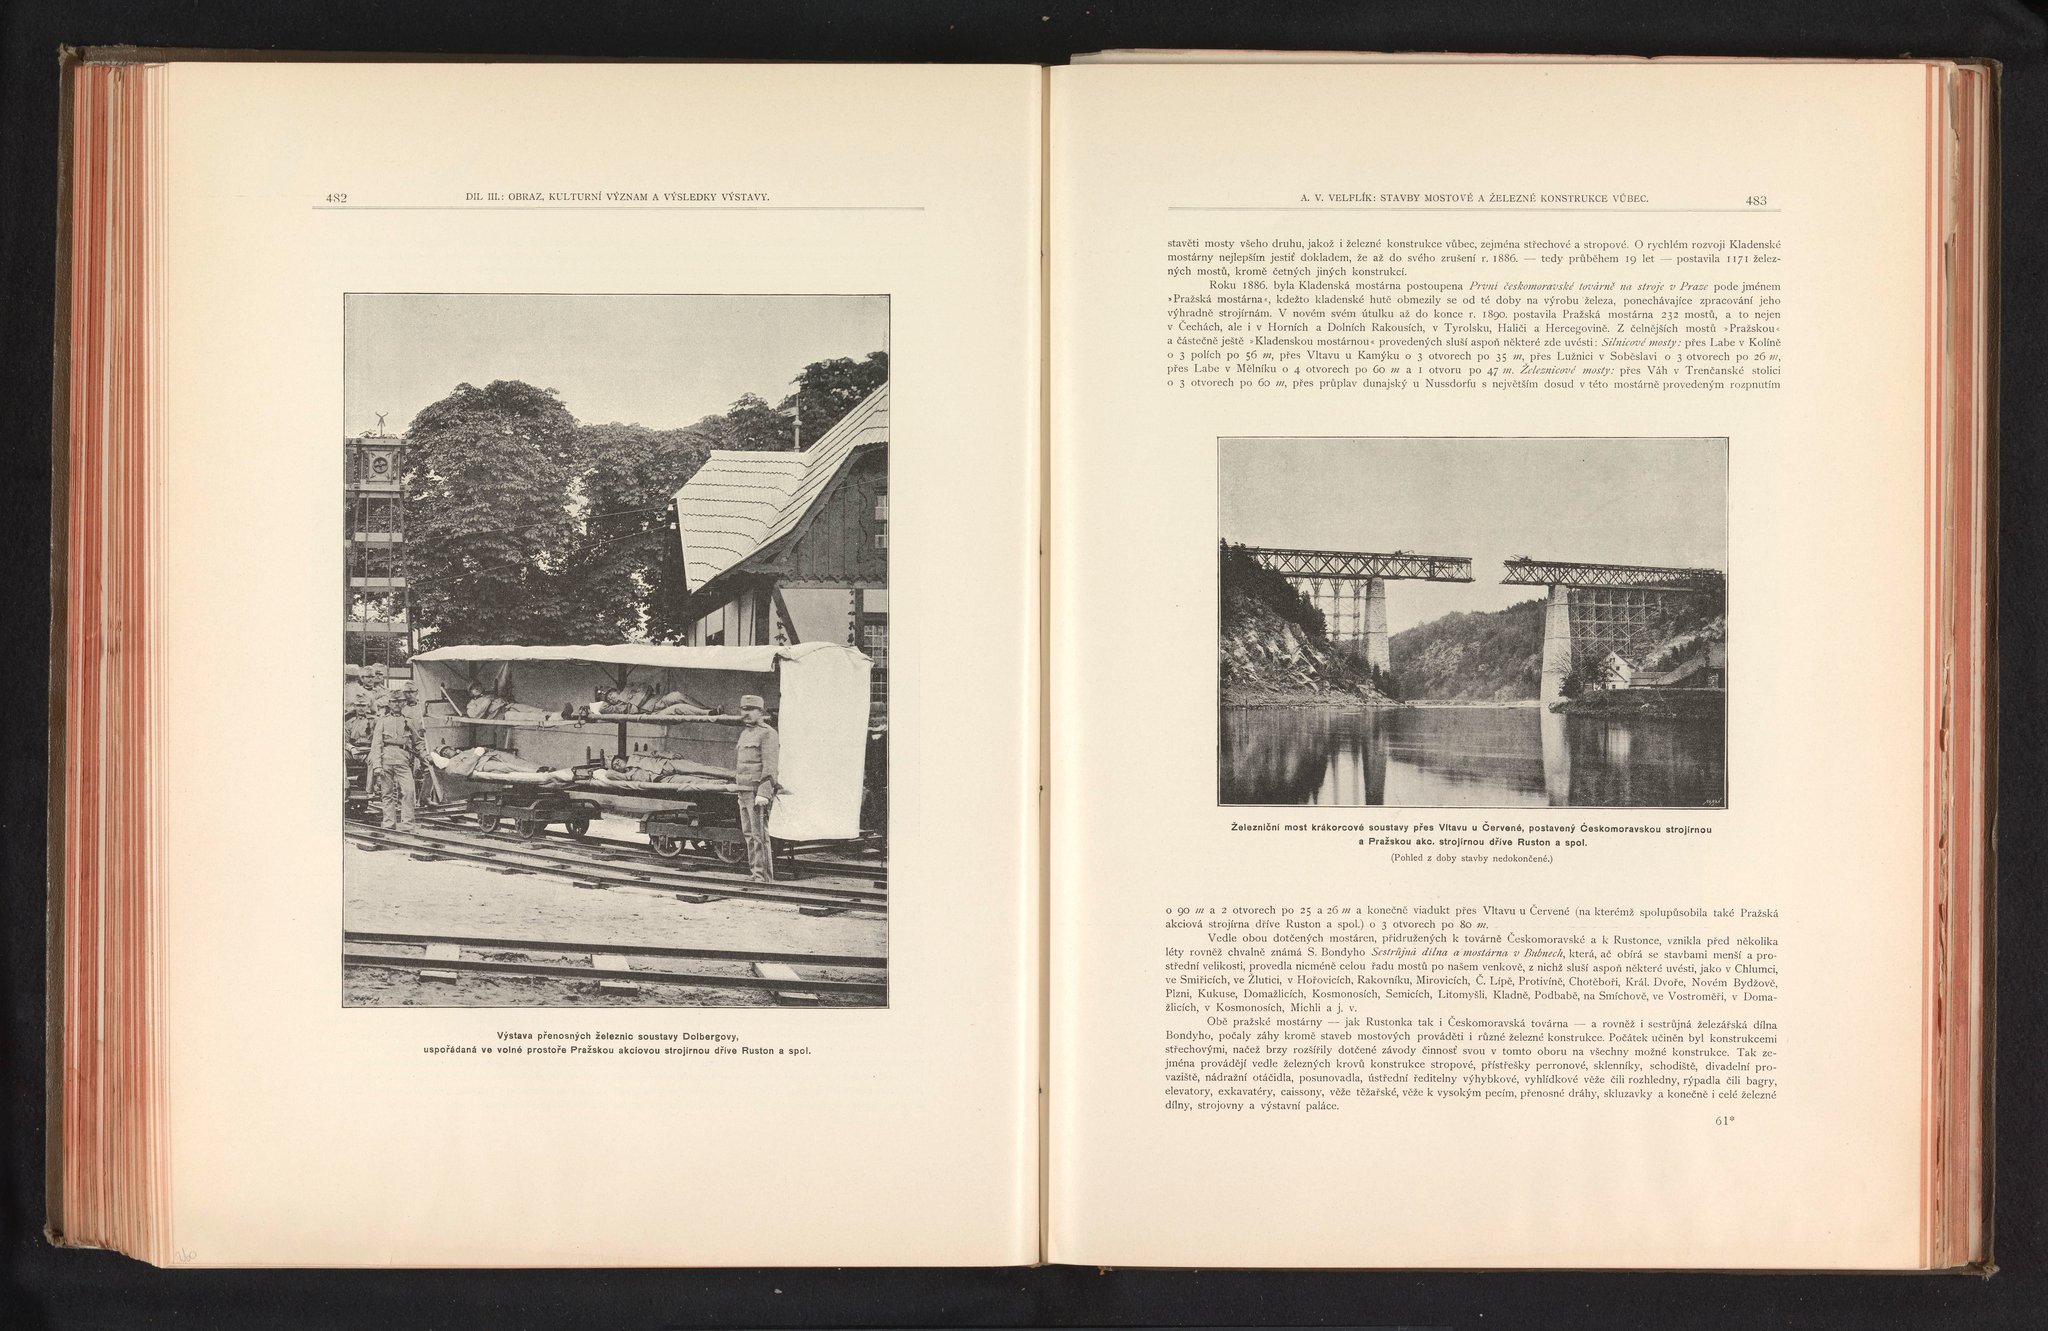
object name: page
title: Výstava prenosných zeleznic soustavy Dolbergovy, uspodaradaná ve volné prostore Prazskou akciovou strojirnou drive Ruston a spol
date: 1891-1895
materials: paper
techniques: autotype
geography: czech republic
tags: railway-coach, railway-carriage, wagon, bed